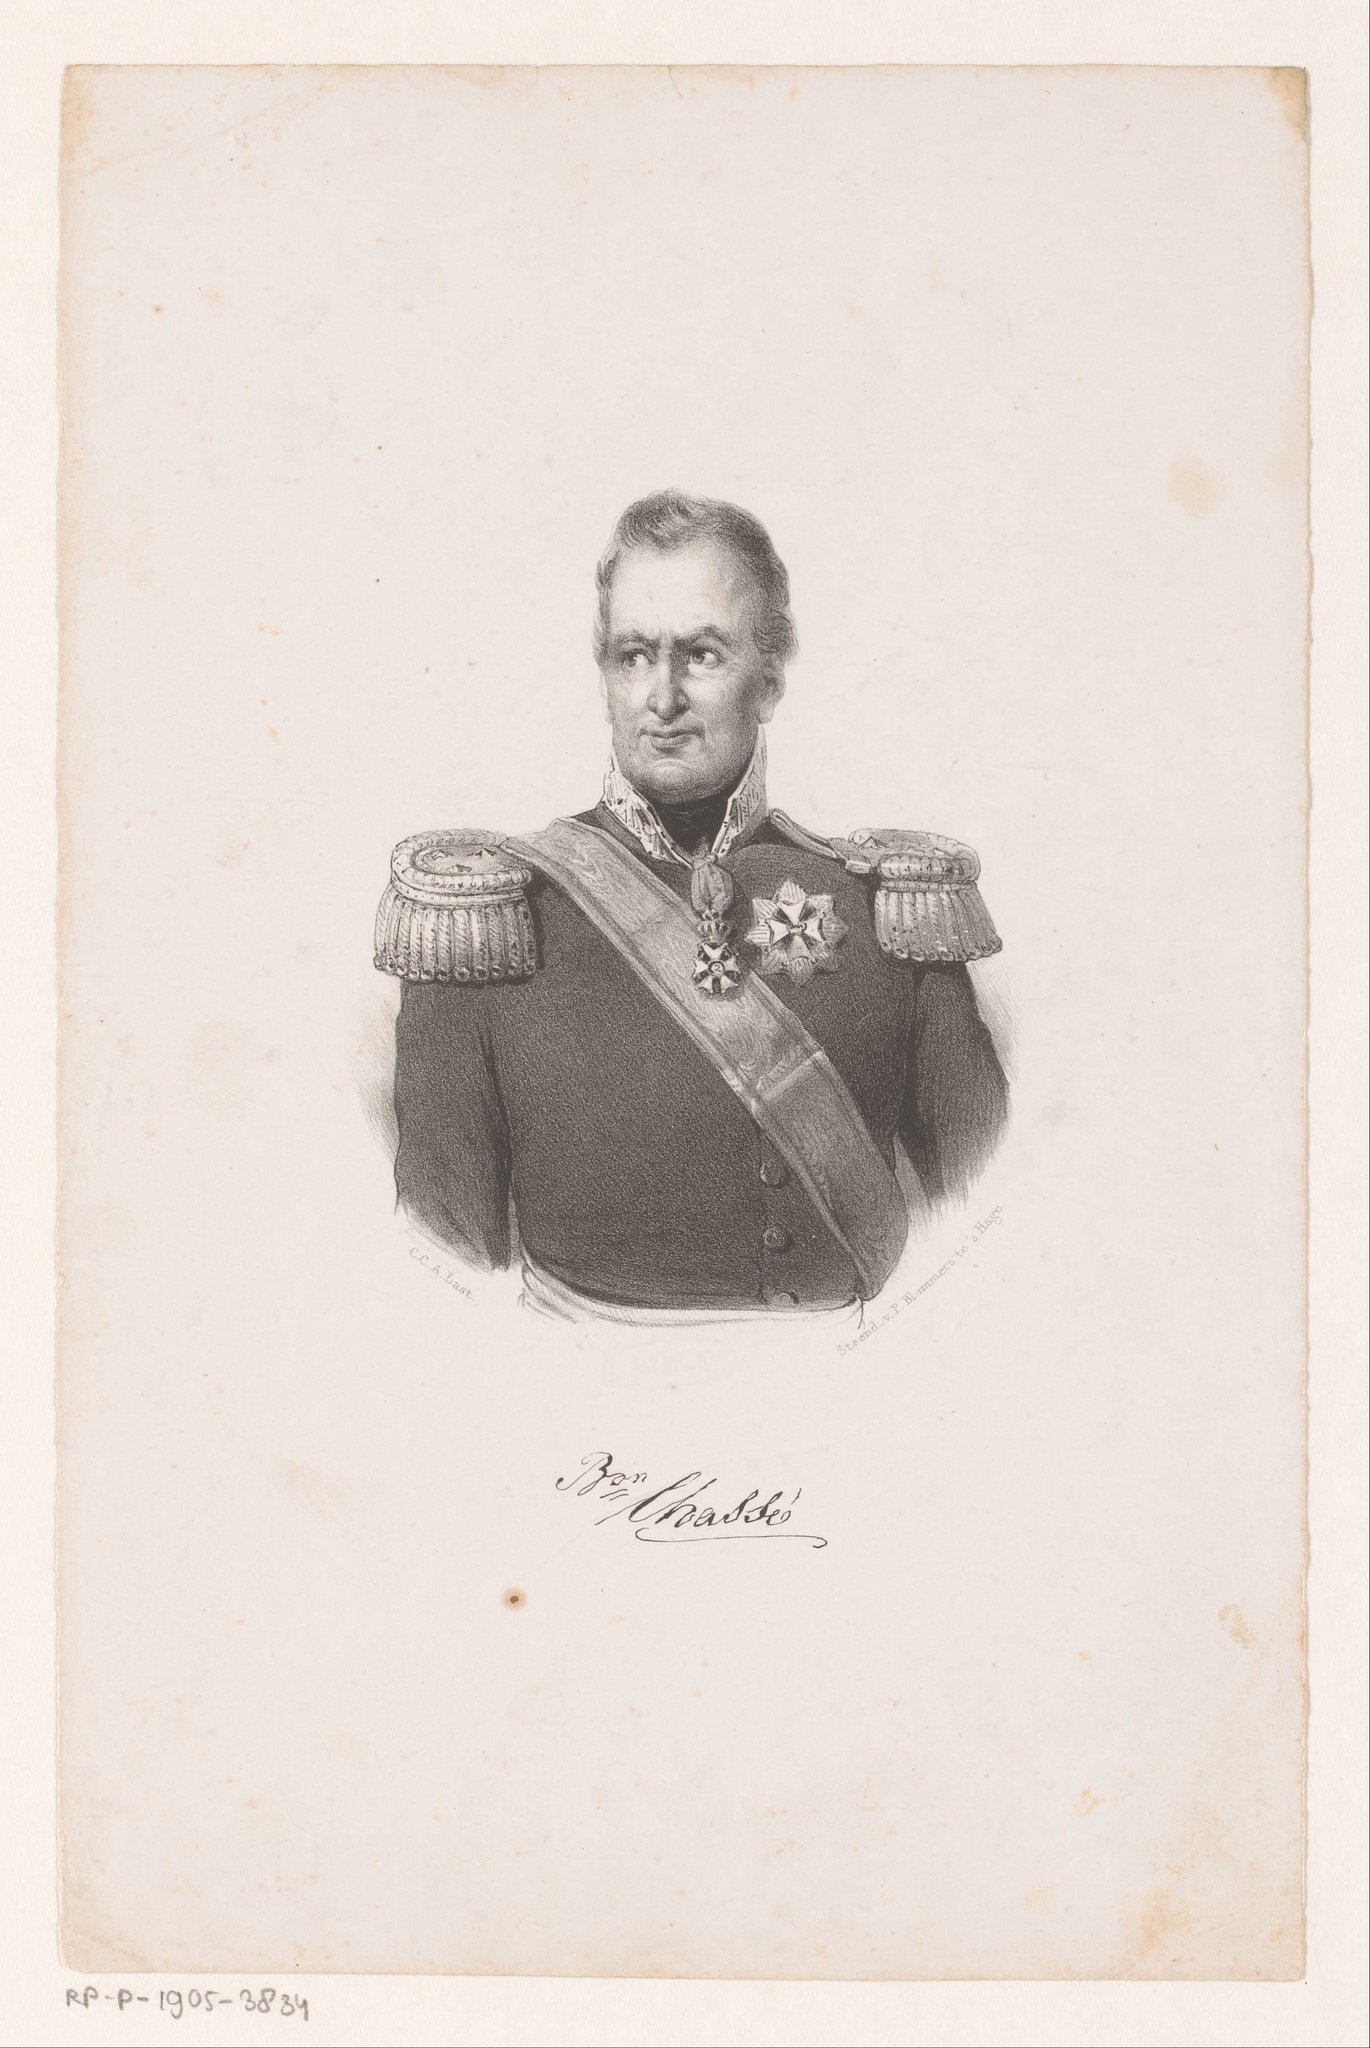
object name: print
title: Portret van David Hendrik baron Chassé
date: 1842-1887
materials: paper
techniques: lithograph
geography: the hague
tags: david hendrik baron chassé, knighthood order, historical persons (+ (full) bust portrait)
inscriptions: collector's mark: Lugt 2228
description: De geportretteerde kijkt naar links, draagt een sjerp en twee ridderorden. Onder het portret zijn signatuur.